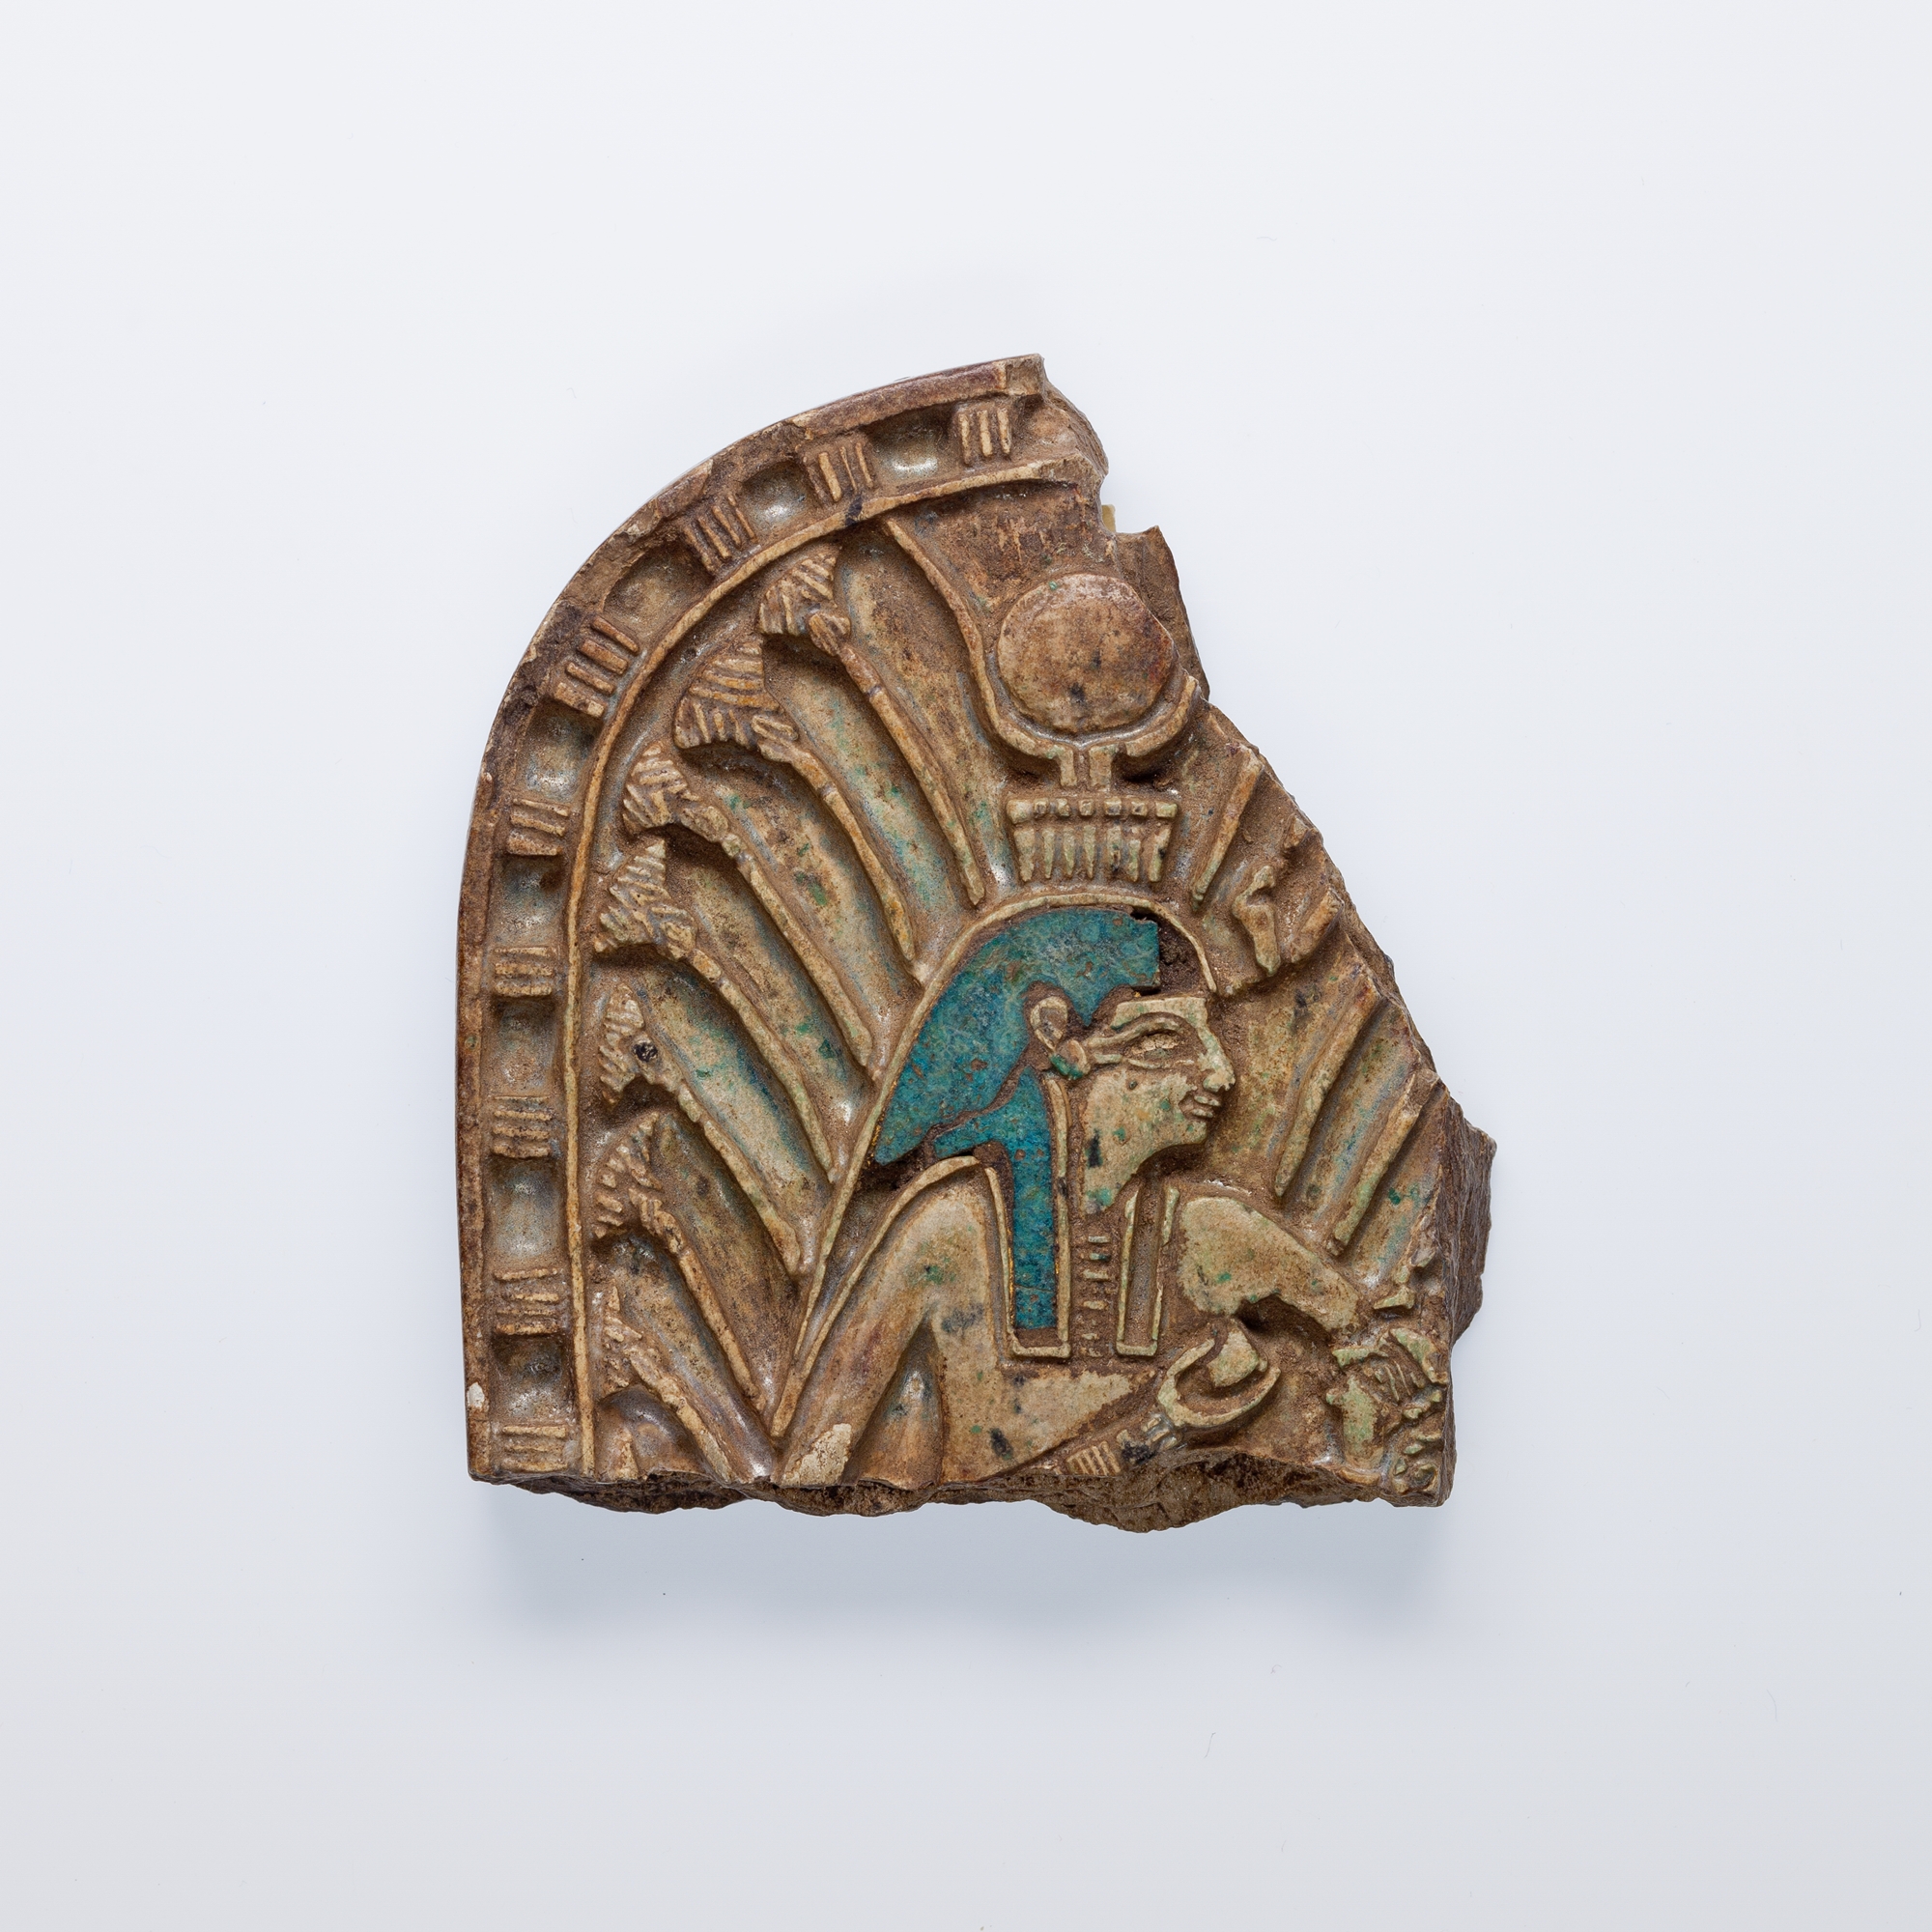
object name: box lid, menat, isi in marsh, horus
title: Isis nursing Horus in the marshes depicted on a fragment from a box lid or menat counterpoise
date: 1070-664 BCE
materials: stone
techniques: glazing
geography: egypt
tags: horus,isis,nursing